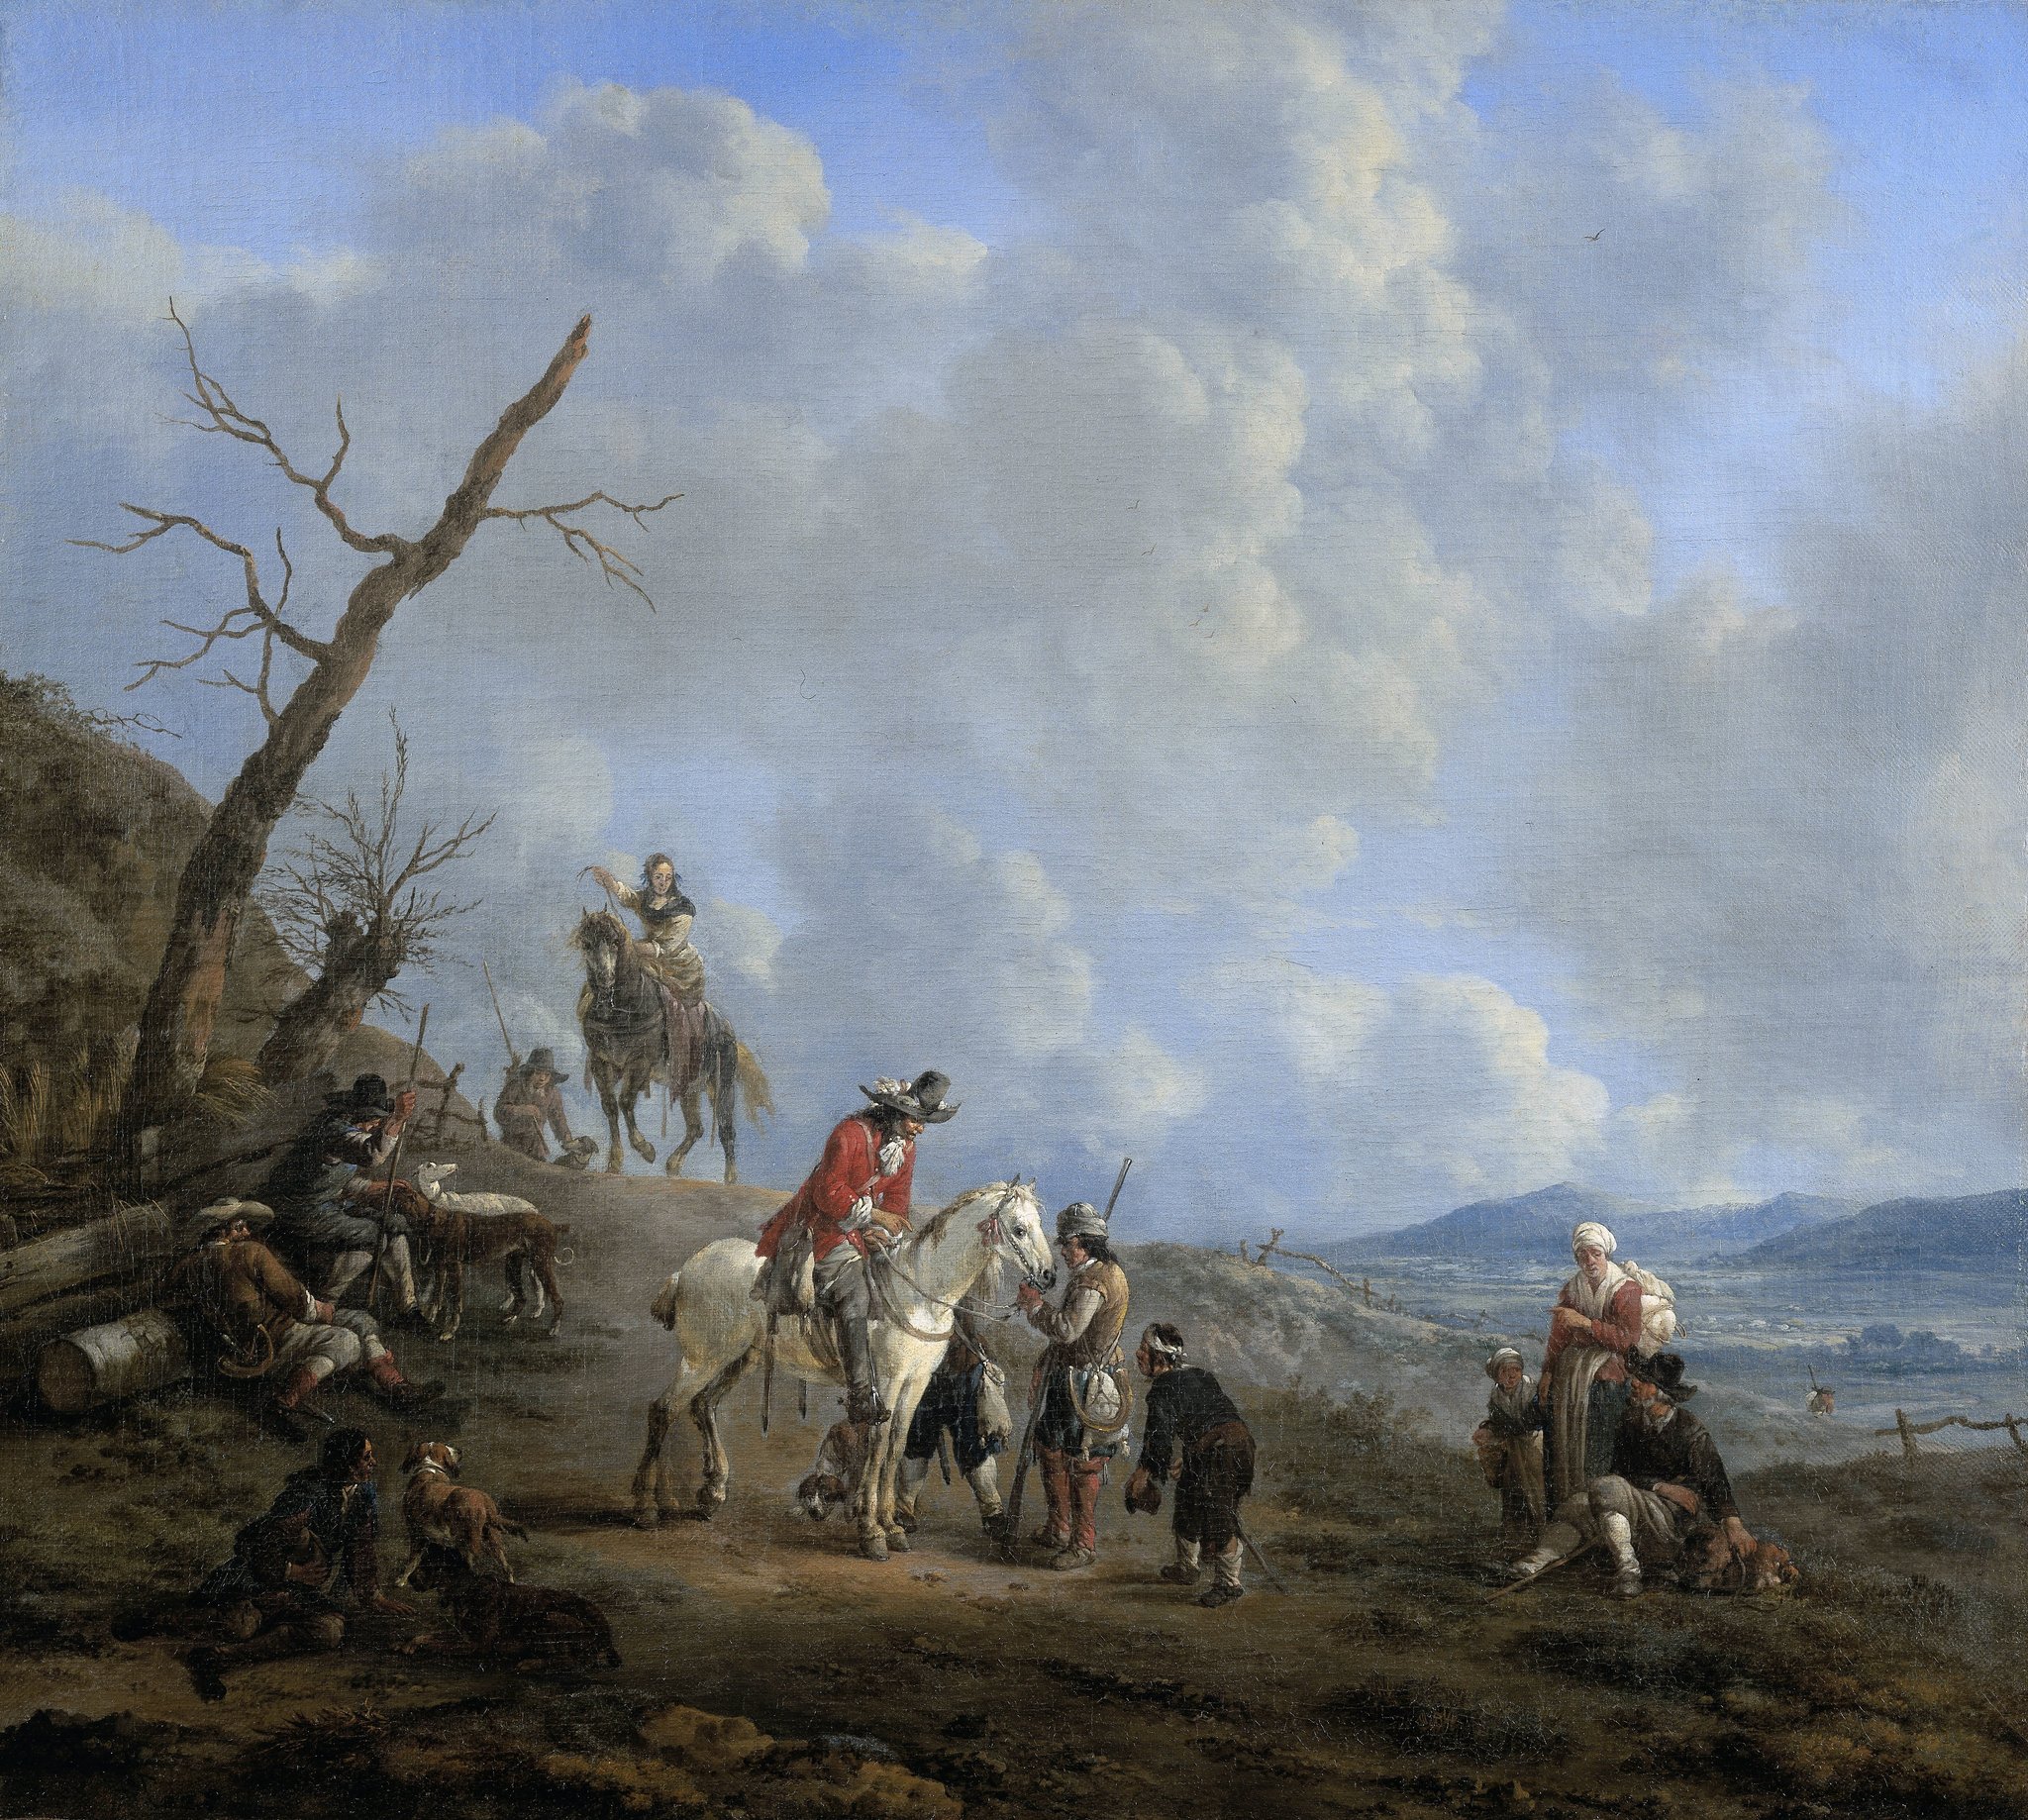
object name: painting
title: Landscape with Riders, Hunters and Peasants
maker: johannes lingelbach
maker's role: draughtsman, painter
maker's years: 1622-1674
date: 1650-1674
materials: canvas, oil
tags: riding a horse, ass, or mule; rider, horseman, hunter, (traveller) resting in the open air, (high) hill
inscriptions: signature: ‘J lingelbach’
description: Landschap met ruiters, jagers met honden en landlieden bij een weg over een heuvel. Links in het verschiet een dal.